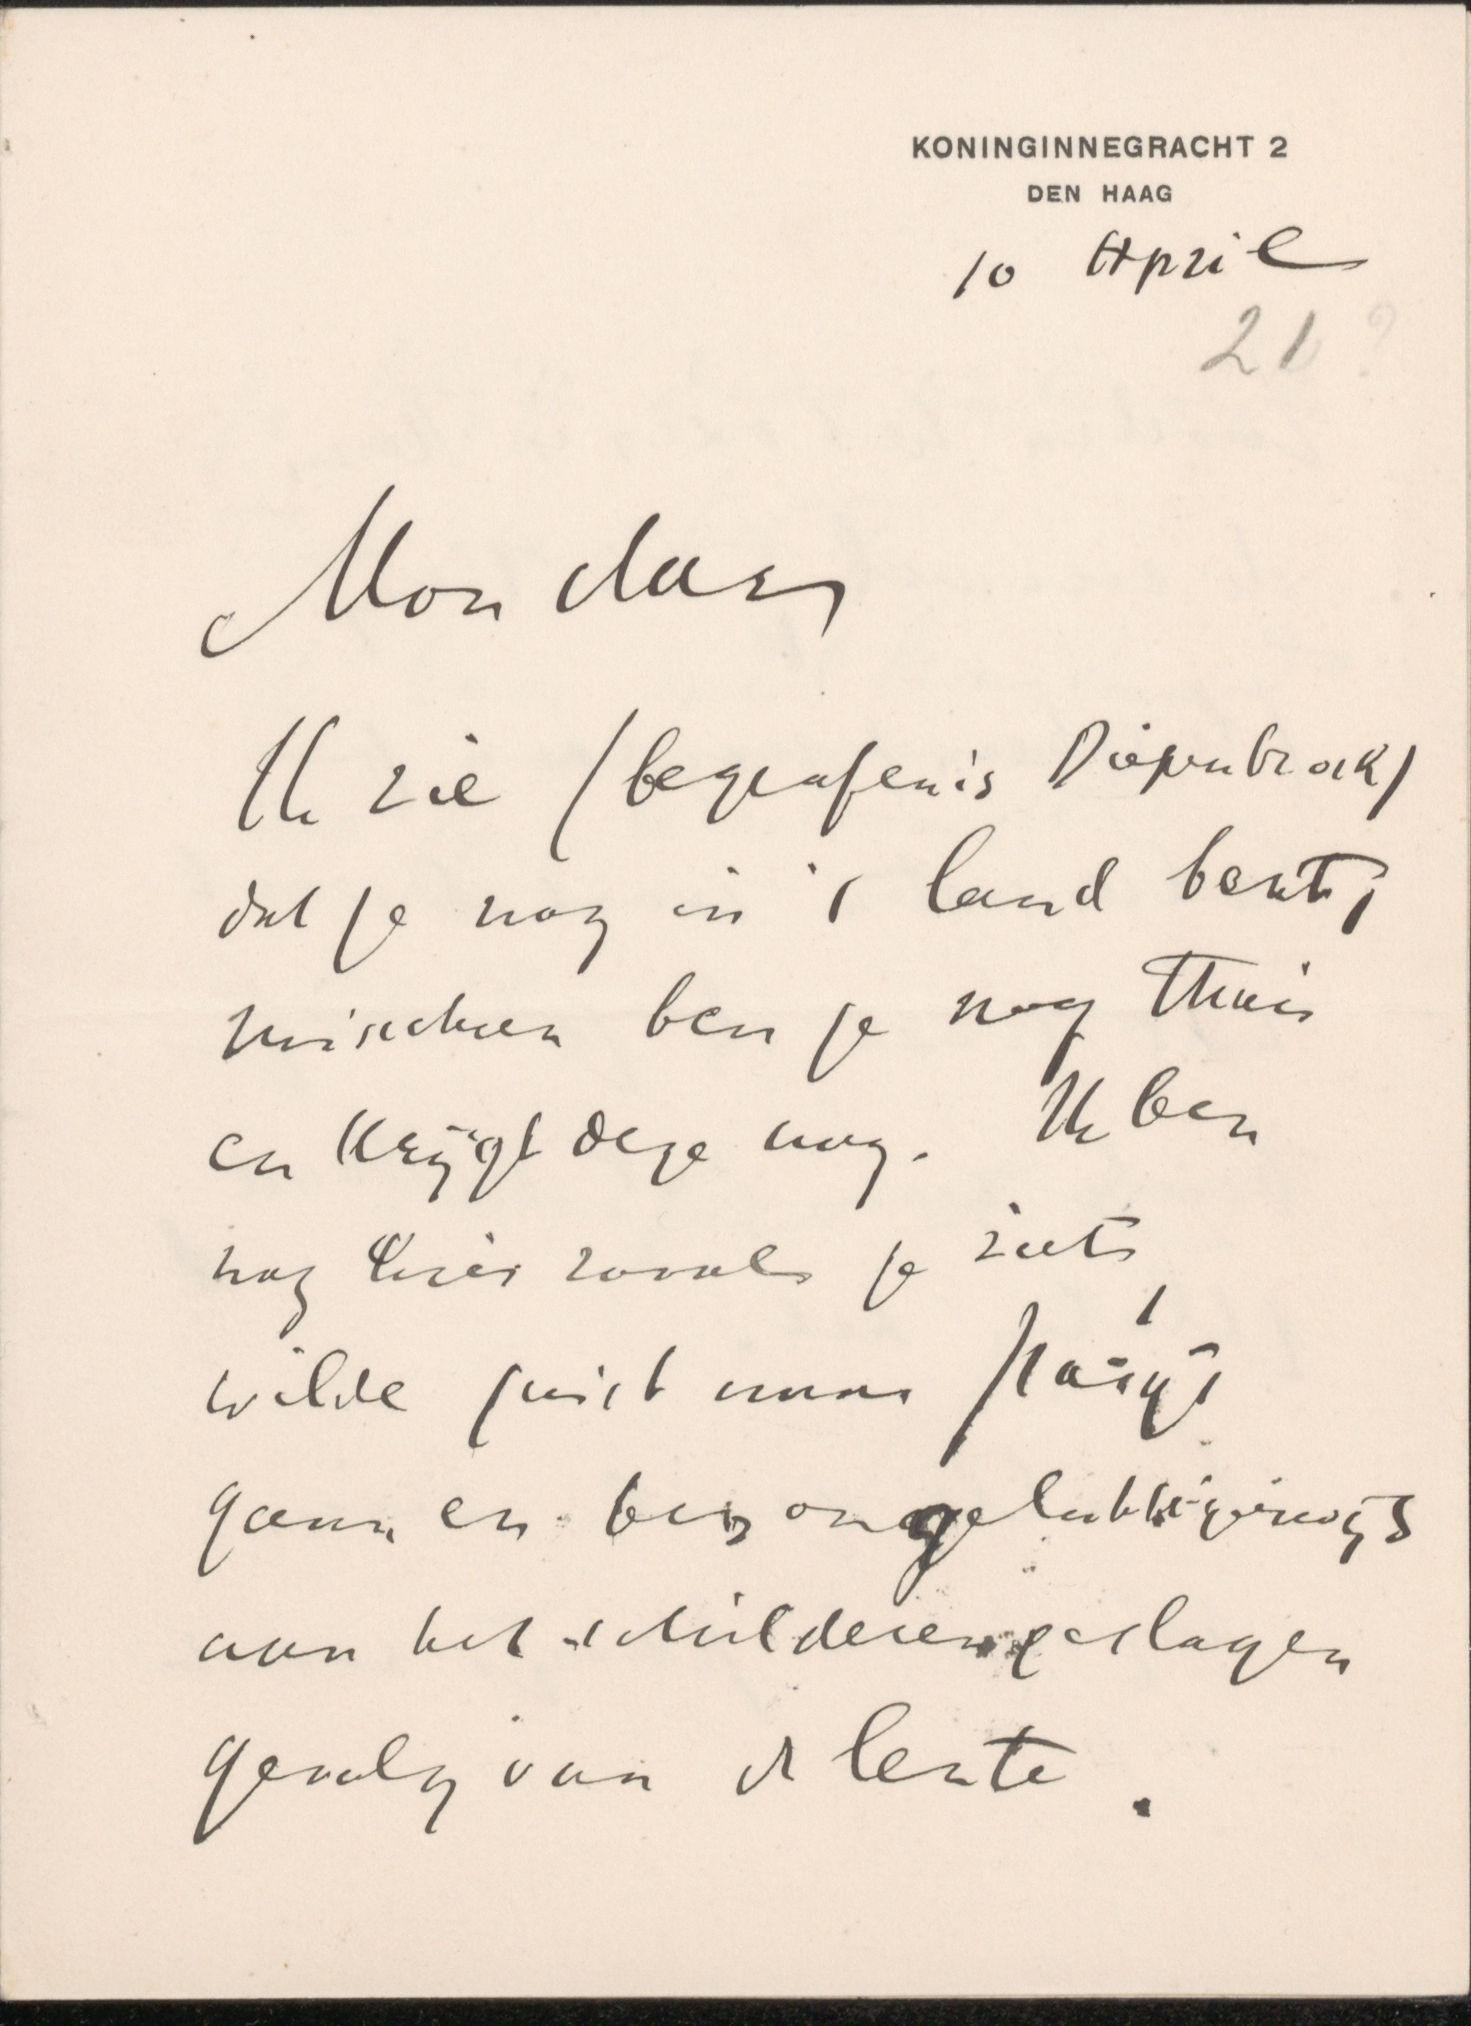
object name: letter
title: Brief aan Jan Veth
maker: isaac israels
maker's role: draughtsman, painter, print maker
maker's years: 1865-1934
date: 1875-1925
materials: ink, paper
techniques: pen, printing, writing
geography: the hague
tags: designer, jan veth, alphons diepenbrock, painting (including book-illumination, miniature-painting), exhibition ~ art, paris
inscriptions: collector's mark: ‘RPK’